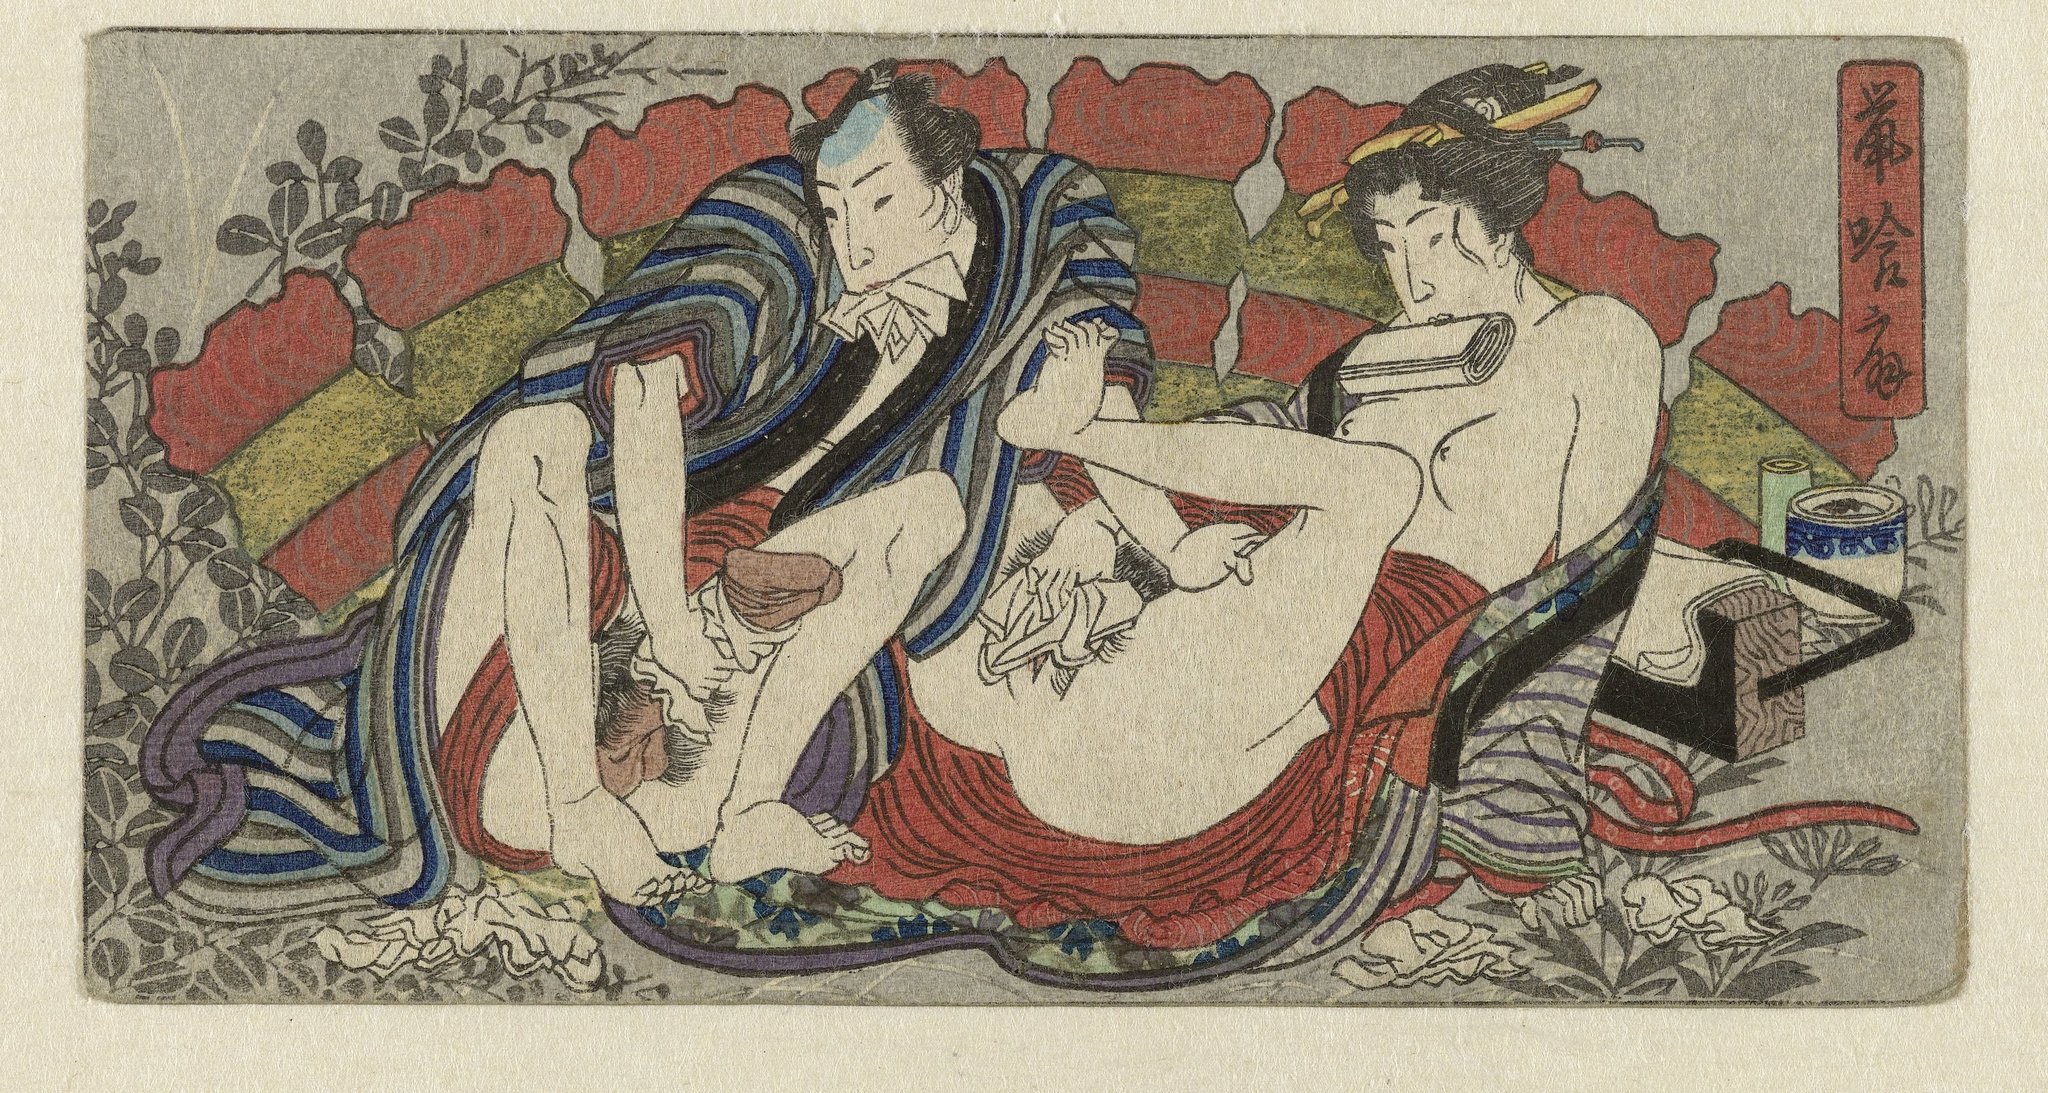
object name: print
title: Sogôsen, de 'muisgeknaagde waaier'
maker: Anonymous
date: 1850-1860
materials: paper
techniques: woodcut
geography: japan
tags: after the intercourse, fan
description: Na de liefdesdaad reinigen een man en een vrouw hun geslachtsdelen met hanagami (papiertjes). De dialoog luidt: "Maak niet zo'n lawaai met dat papier. Wees stil, anders worden ze wakker en merken ze het". Achter hen een waaier.